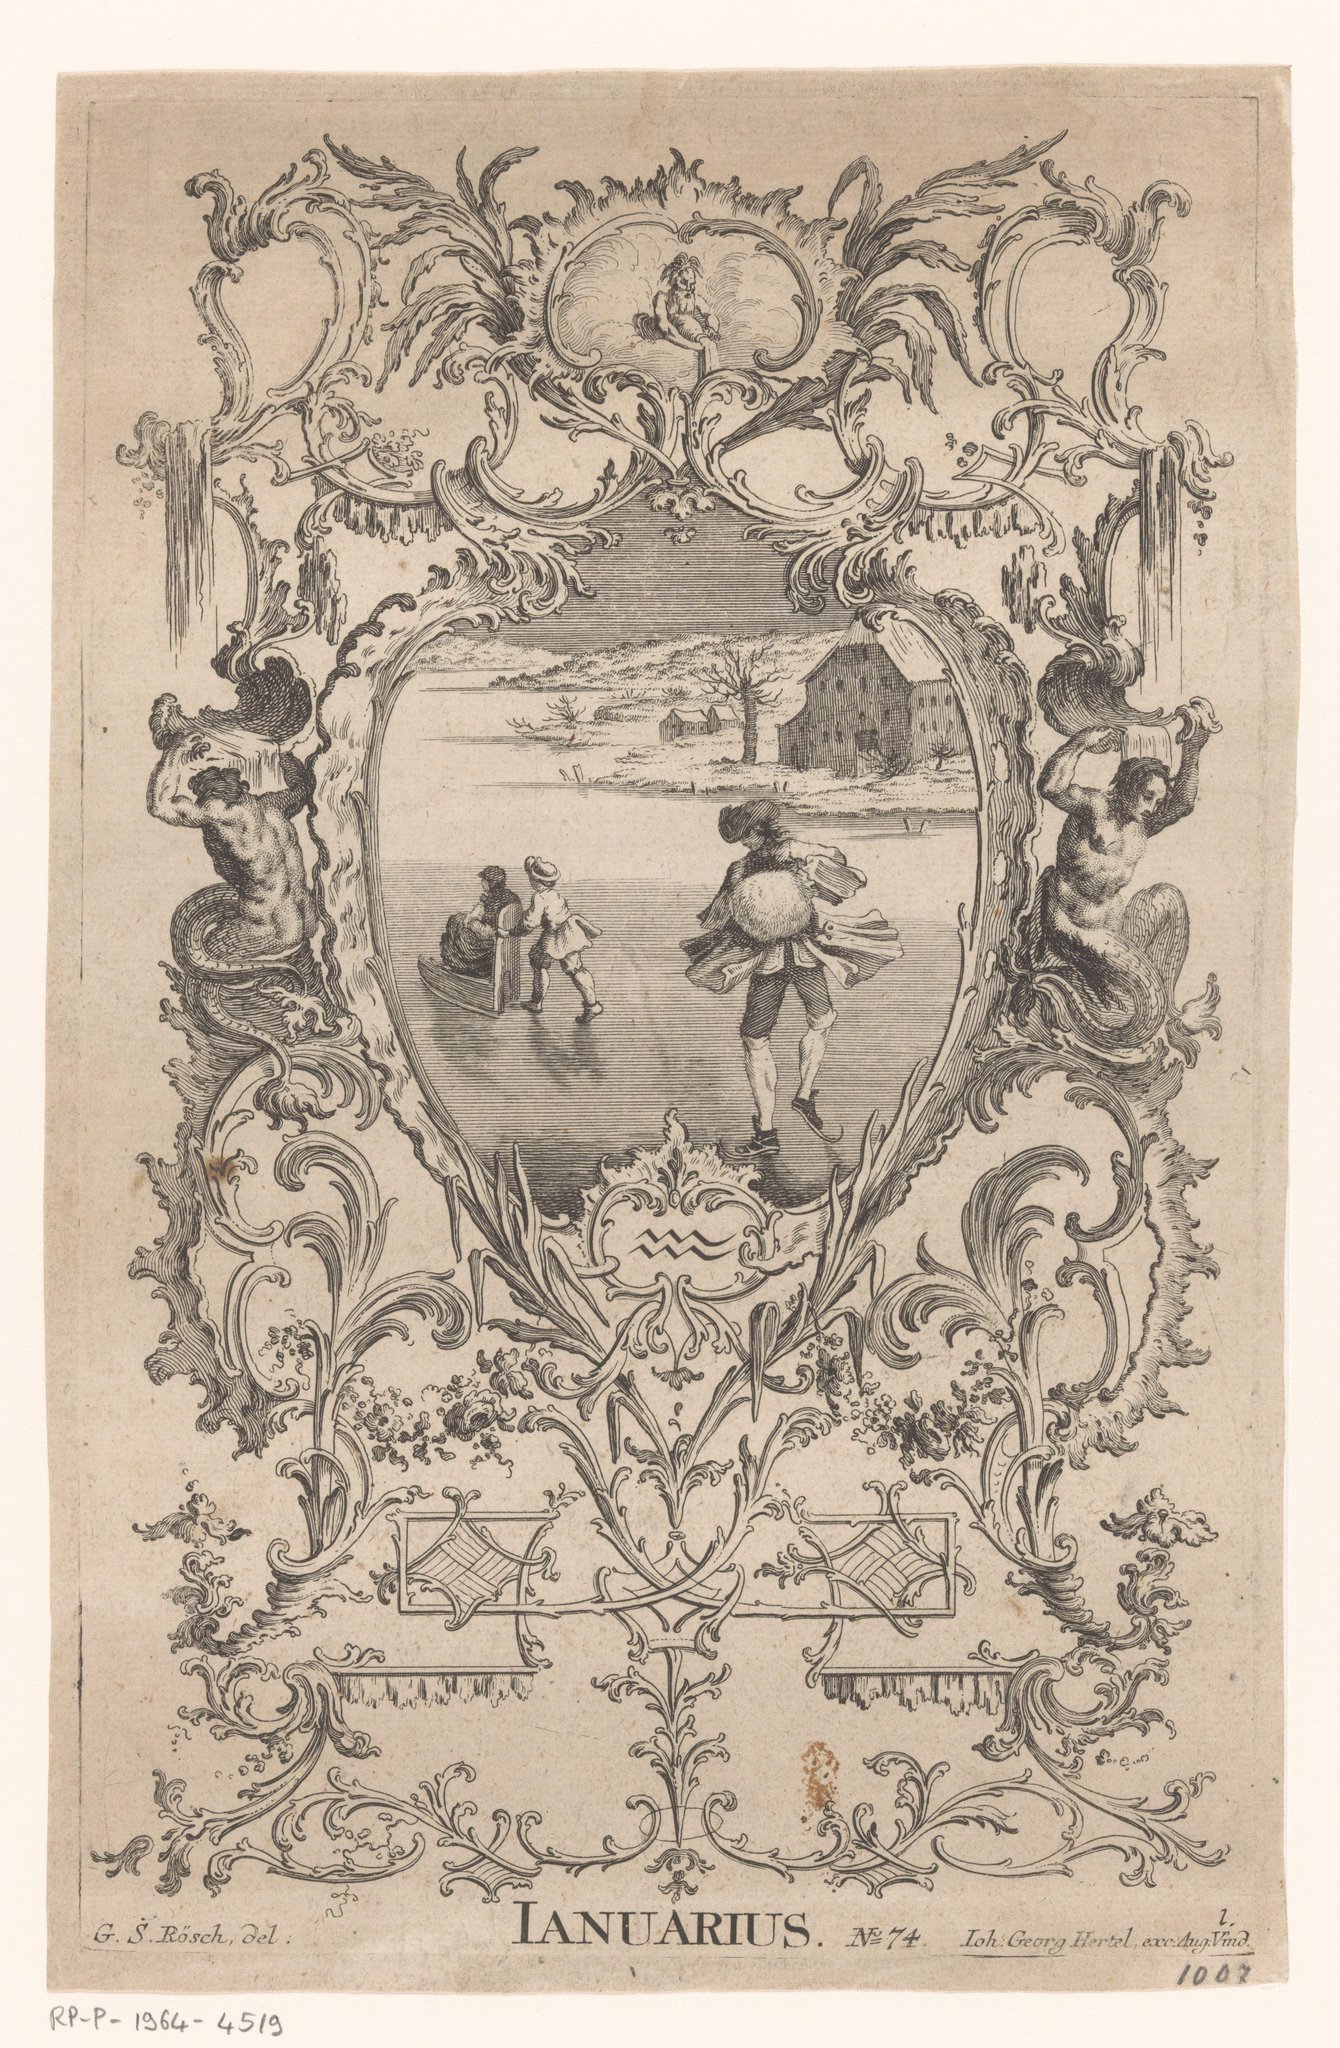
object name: ornament print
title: Januari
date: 1705-1766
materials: paper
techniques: etching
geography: augsburg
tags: january and its 'labours', skates (winter sports), sledge, sleigh (winter sports)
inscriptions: collector's mark: Lugt 2228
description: In een rocaille cartouche schaatsende en sleeënde figuren. Rondom de voorstelling rocaille ornamenten, bloemmotieven, een waterman, het bijbehorende teken van de dierenriem en twee fantasiefiguren. Uitgeversnummer 74.